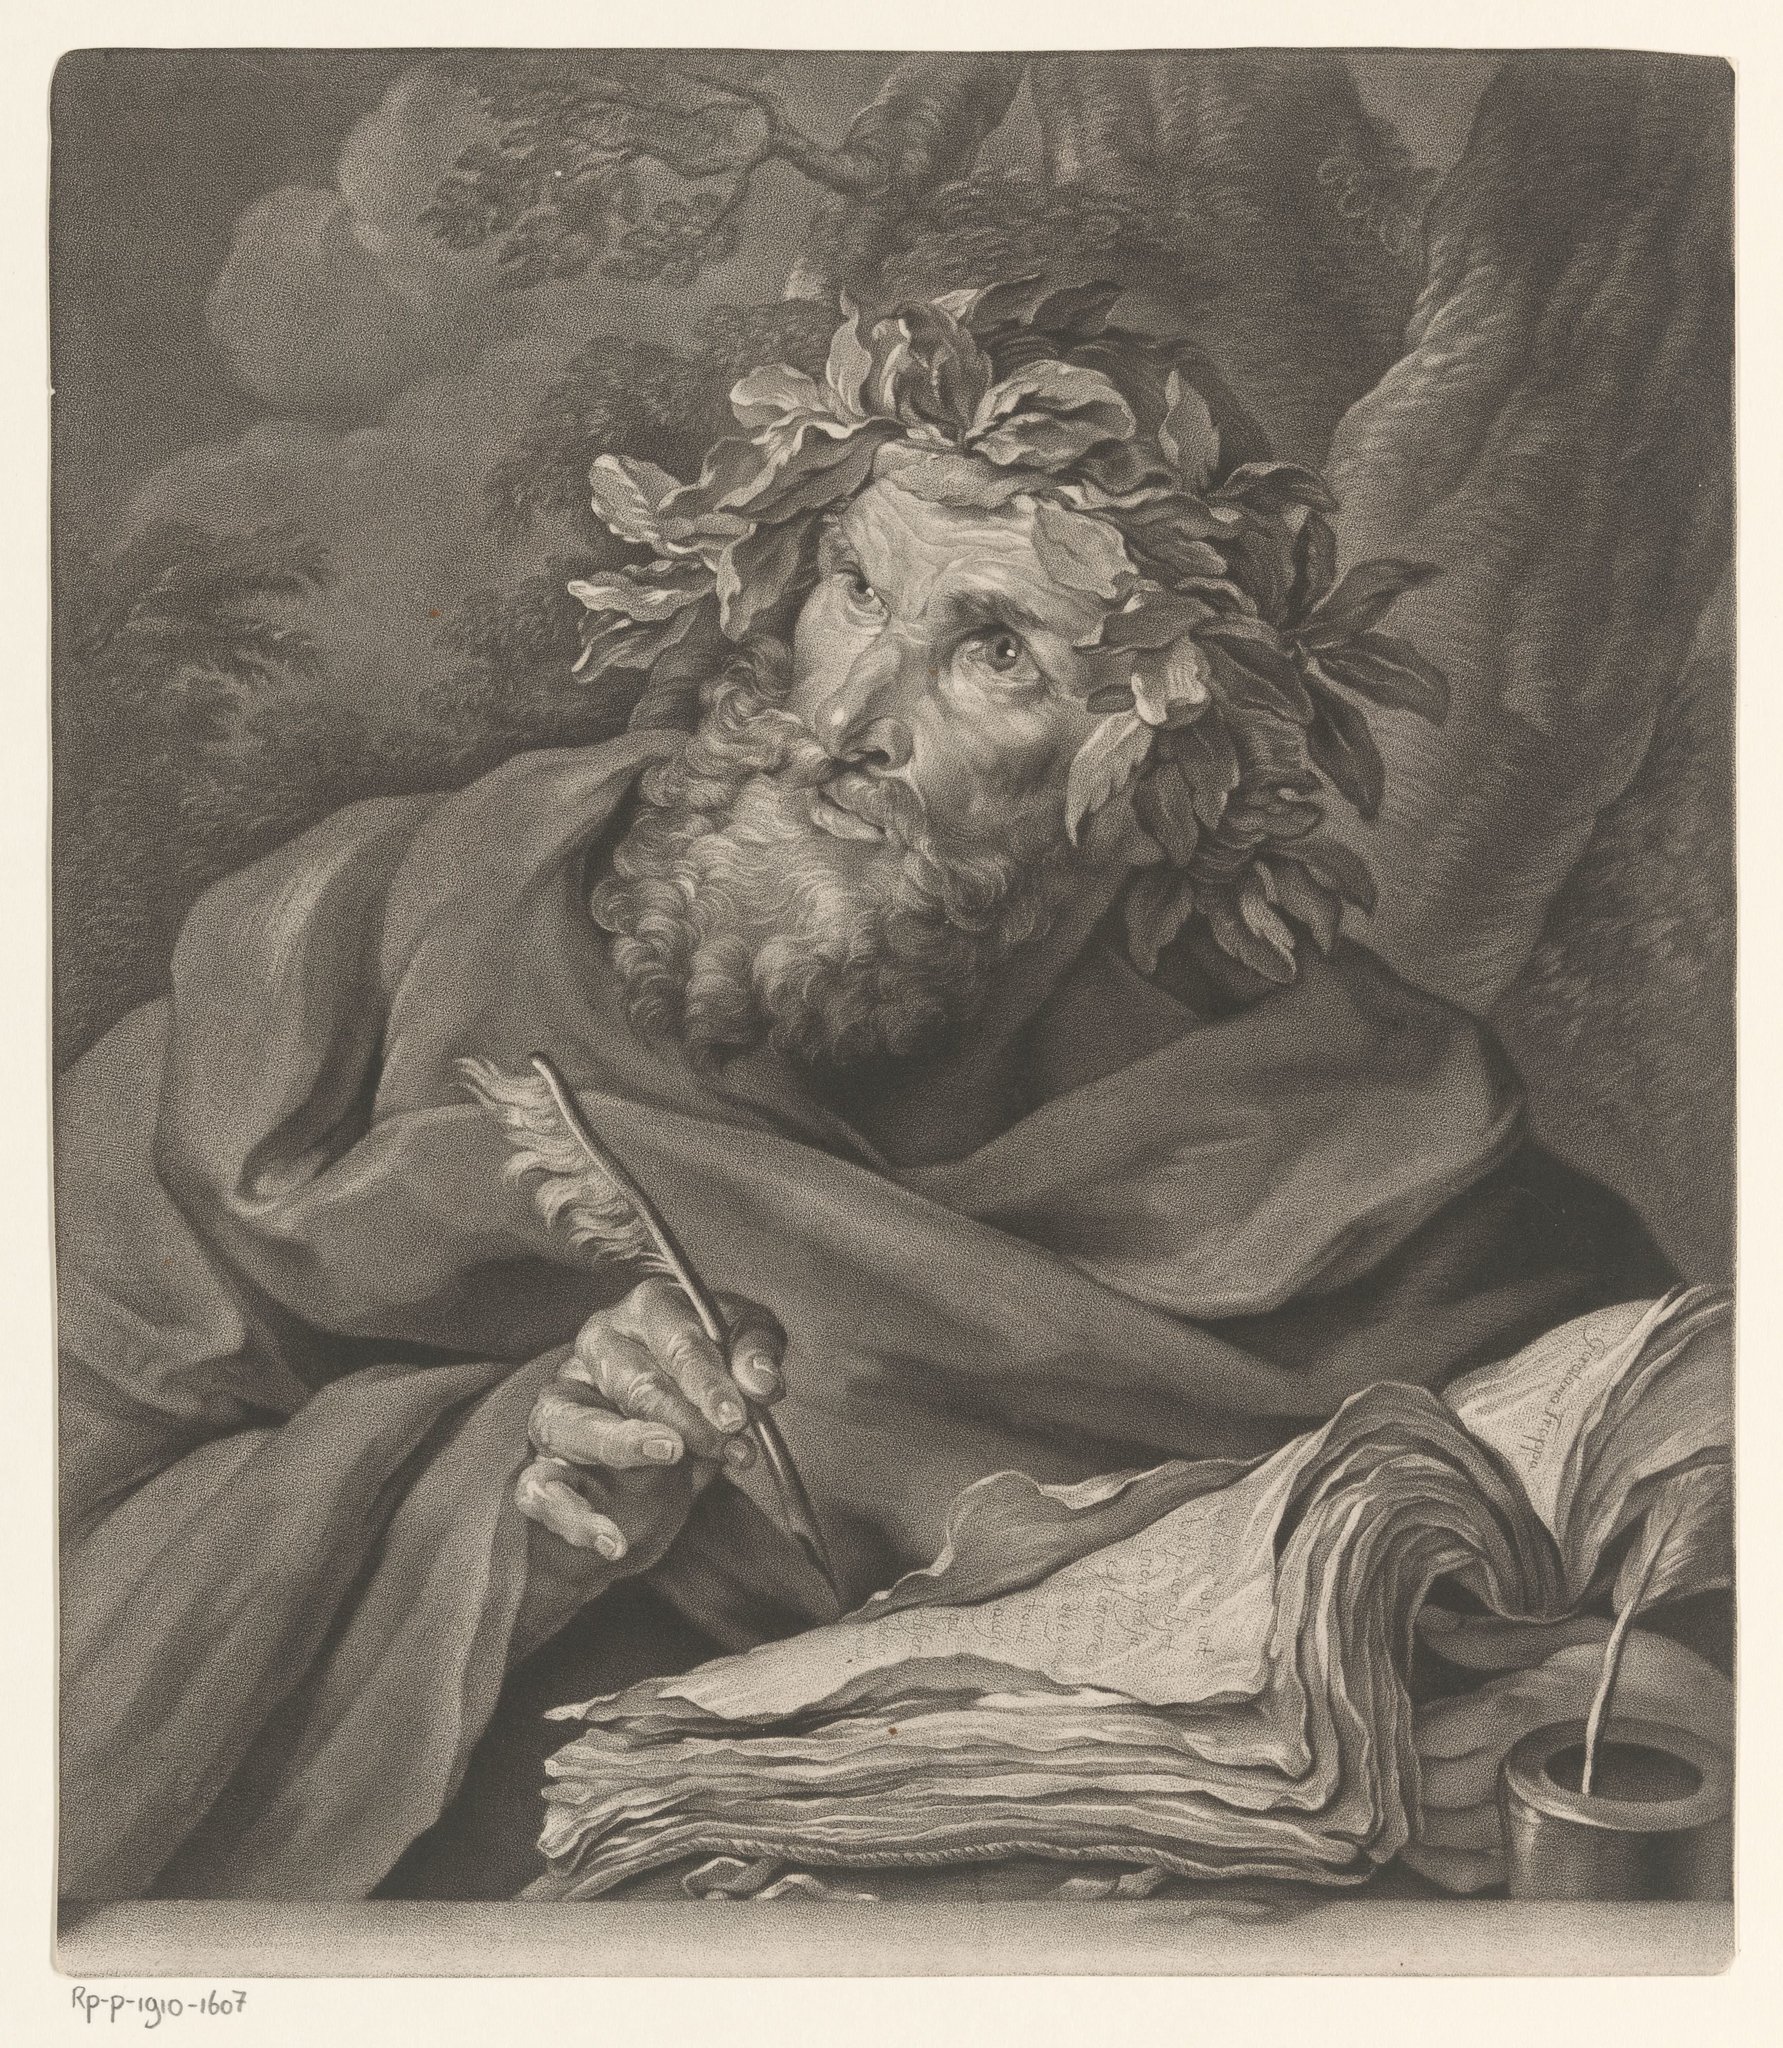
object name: print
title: Lezende evangelist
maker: valentin daniel preissler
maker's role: print maker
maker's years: 1717-1765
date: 1753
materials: paper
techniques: mezzotint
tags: evangelists, usually with books or scrolls (not in biblical context), reading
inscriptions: collector's mark: Lugt 2228